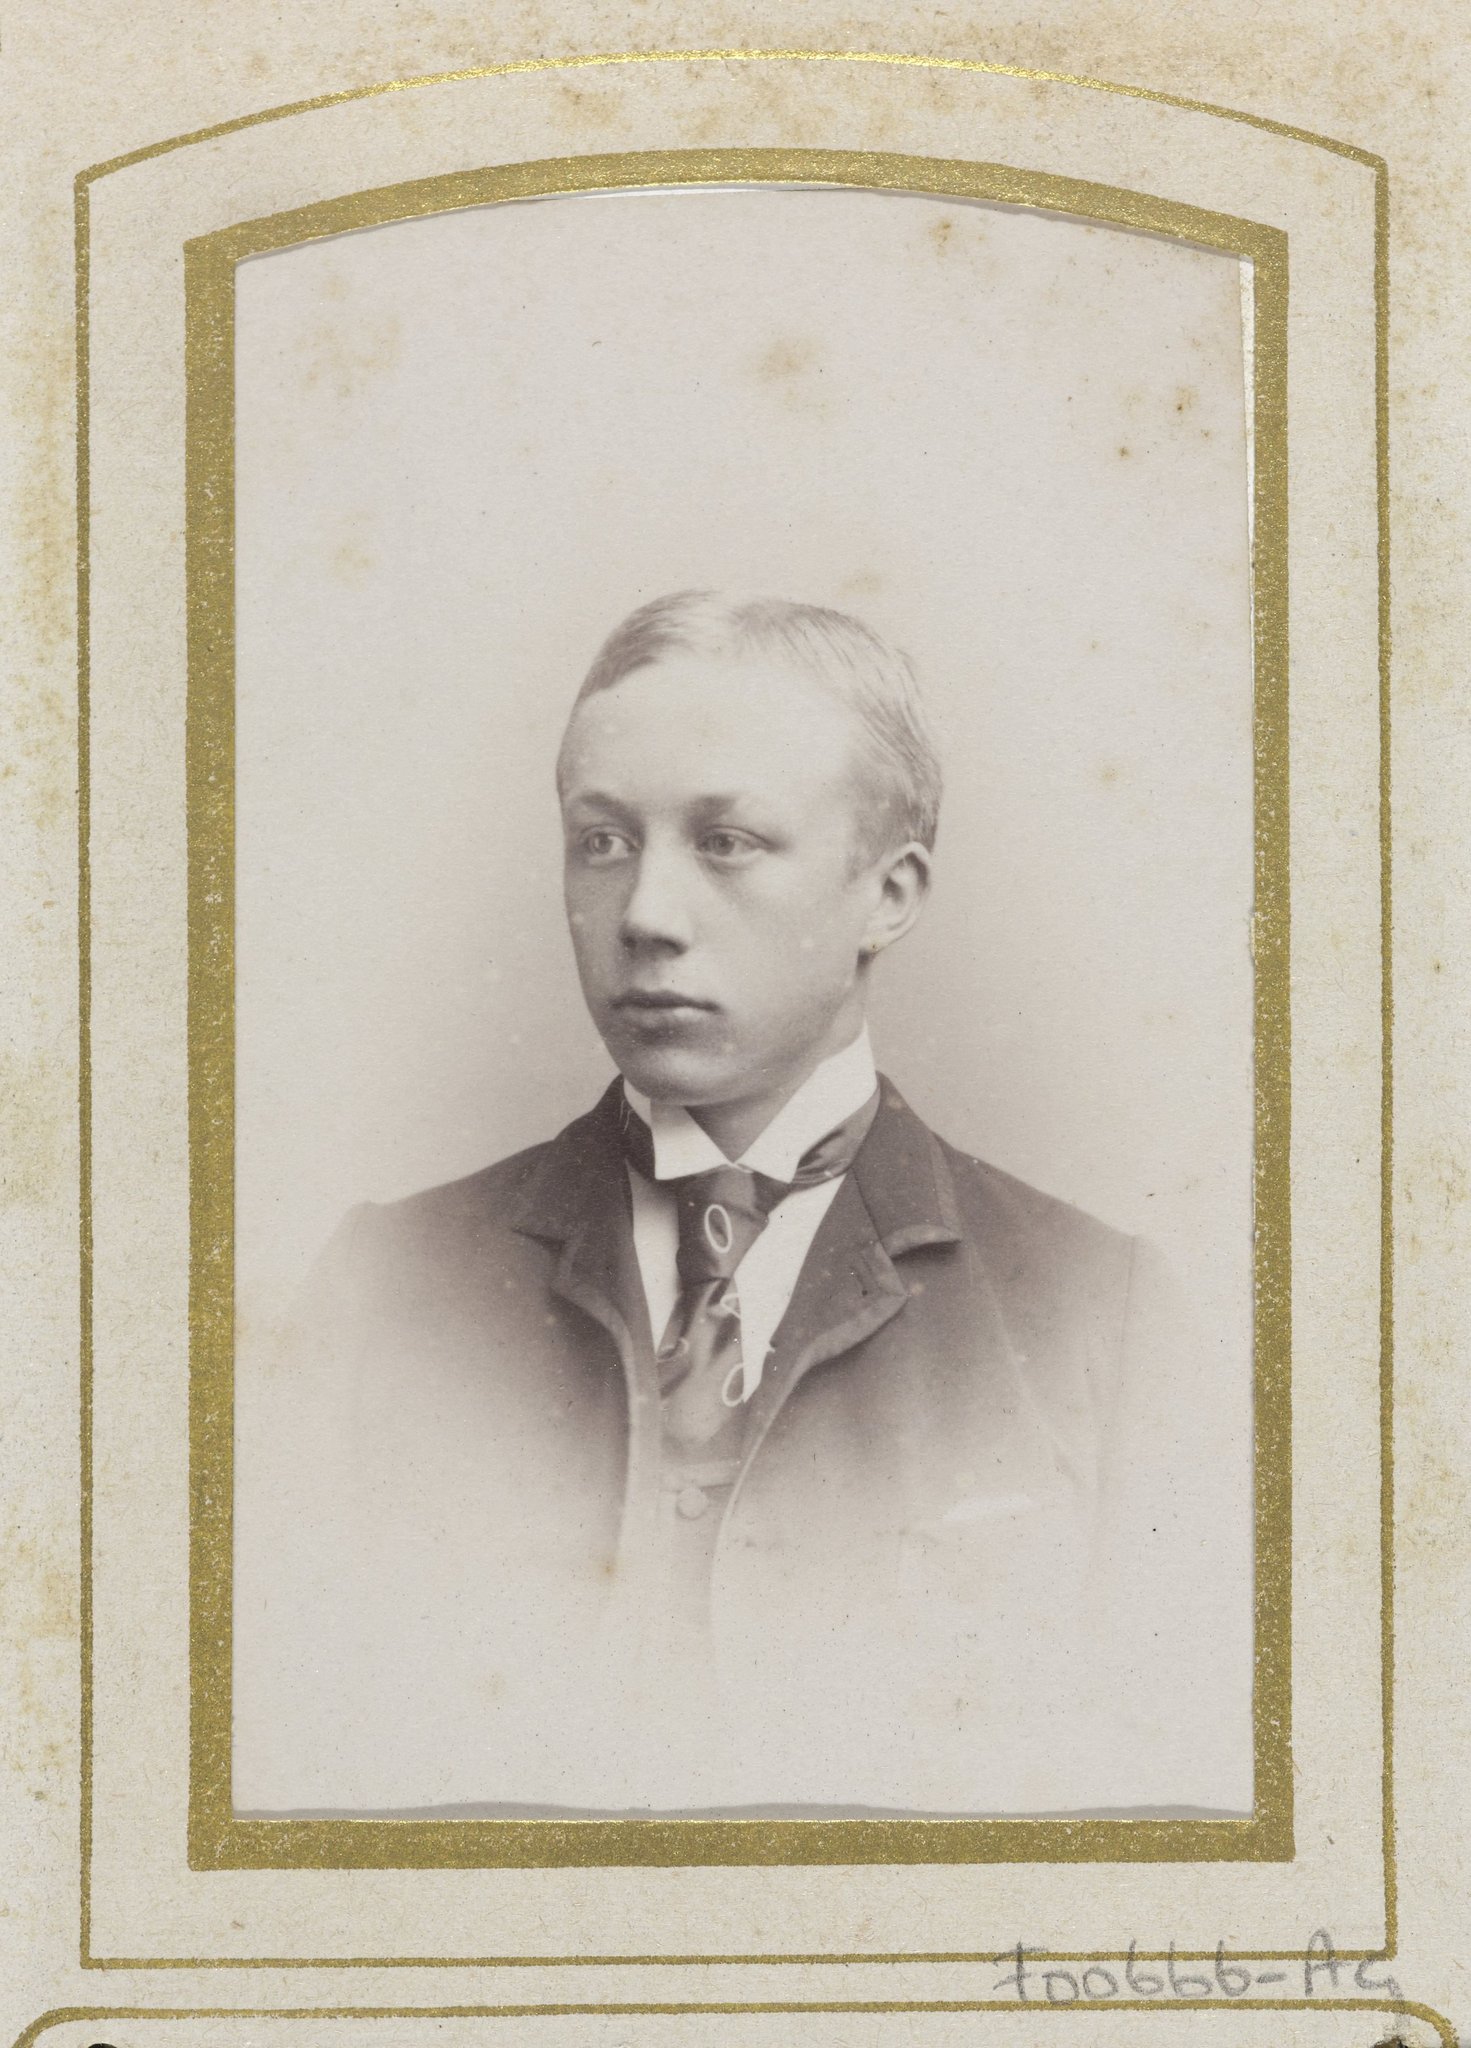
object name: photograph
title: Portret van een jonge man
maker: johan christiaan reesinck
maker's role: fotograaf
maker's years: 1838-1922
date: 1863-1900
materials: cardboard, photographic support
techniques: albumen print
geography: zutphen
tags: historical persons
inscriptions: inscription: ‘J. C. REESINCK/ ZUTPHEN/ BERKELKADE B. 300./ Het cliché blijft voor nabestelling bewaard.’